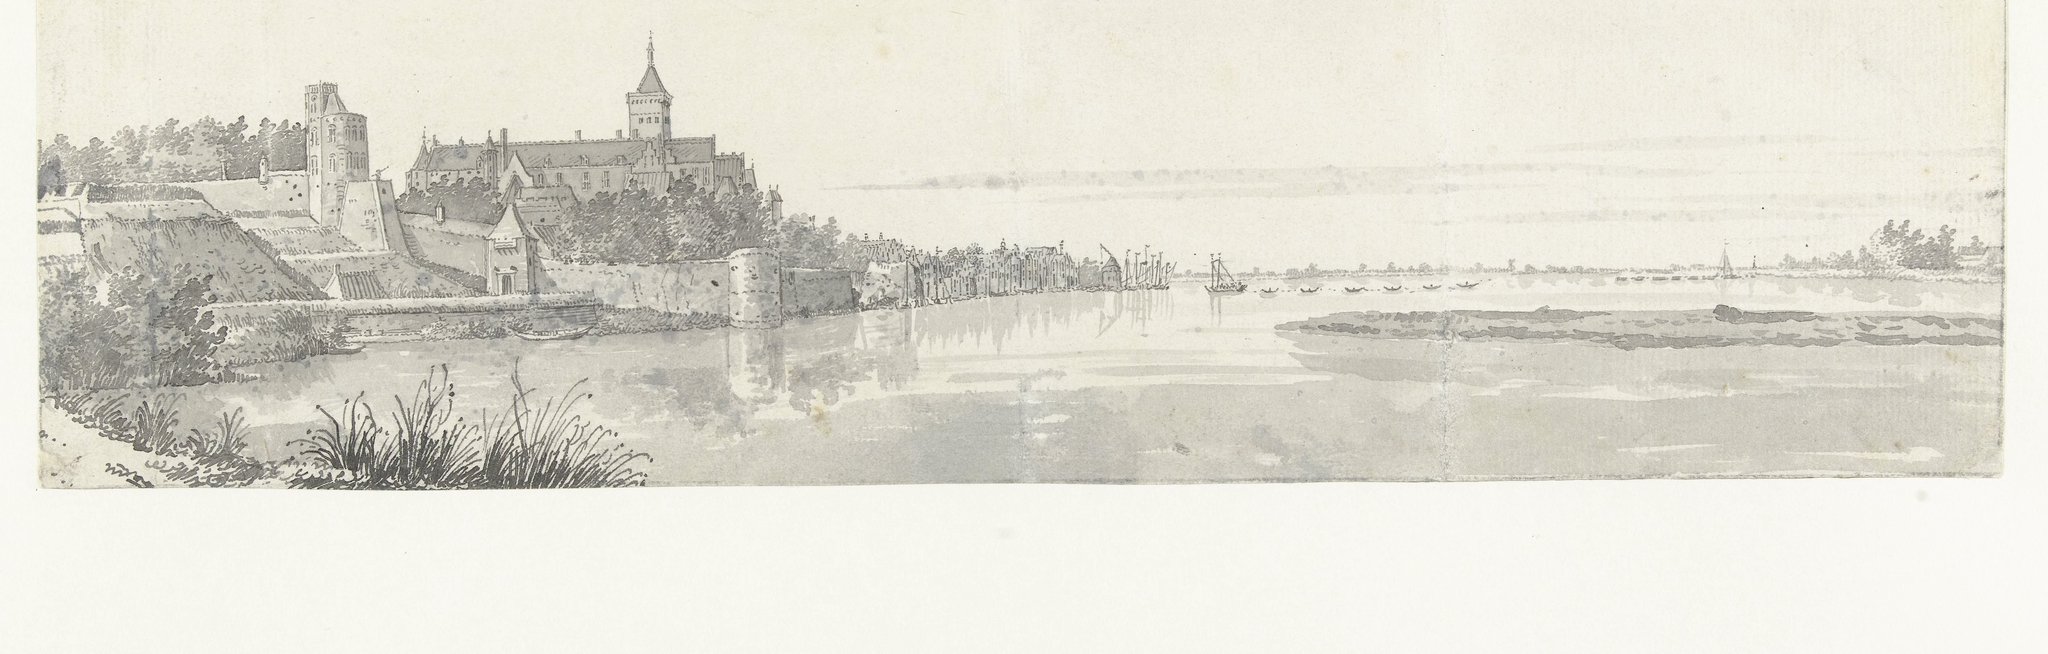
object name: drawing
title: Gezicht op Nijmegen en de Waal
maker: jan de beijer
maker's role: draughtsman, print maker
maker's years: 1703-1780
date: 1752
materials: ink, paper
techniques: brush, pen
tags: river, prospect of city, town panorama, silhouette of city, nijmegen